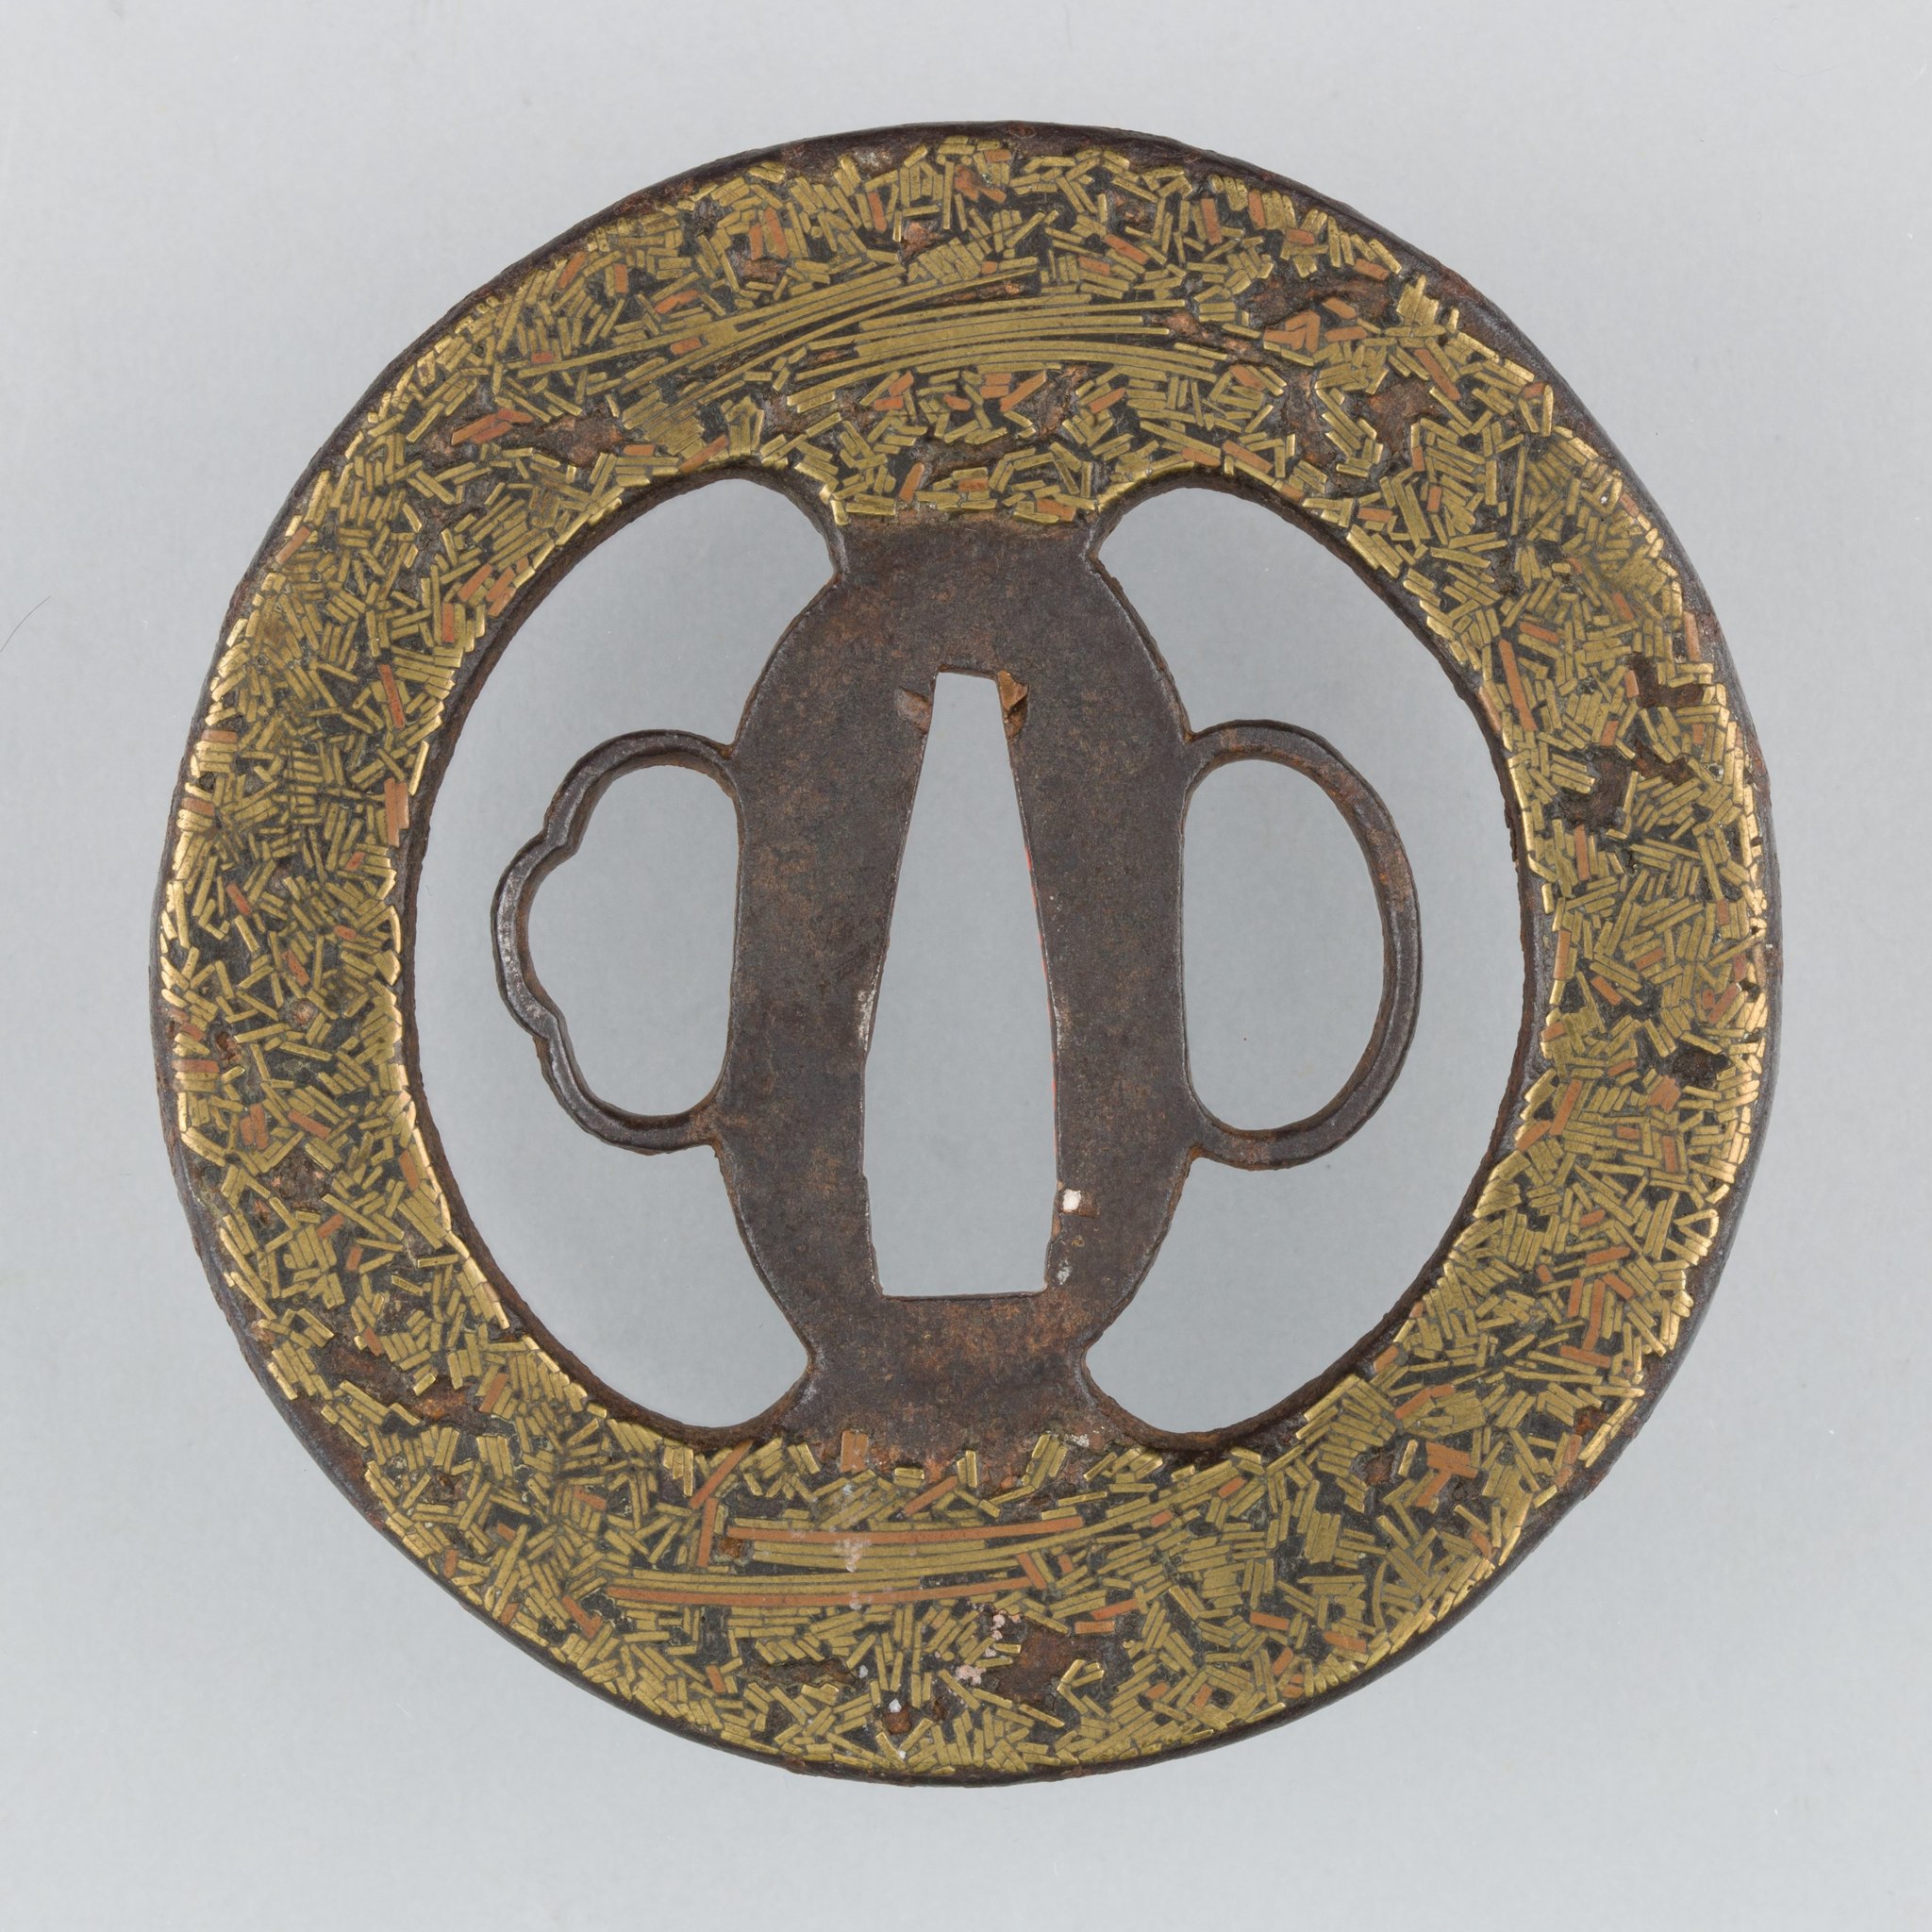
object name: sword guard tsuba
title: Sword Guard (Tsuba)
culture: japanese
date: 1601-1700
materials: brass, copper, iron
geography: japan